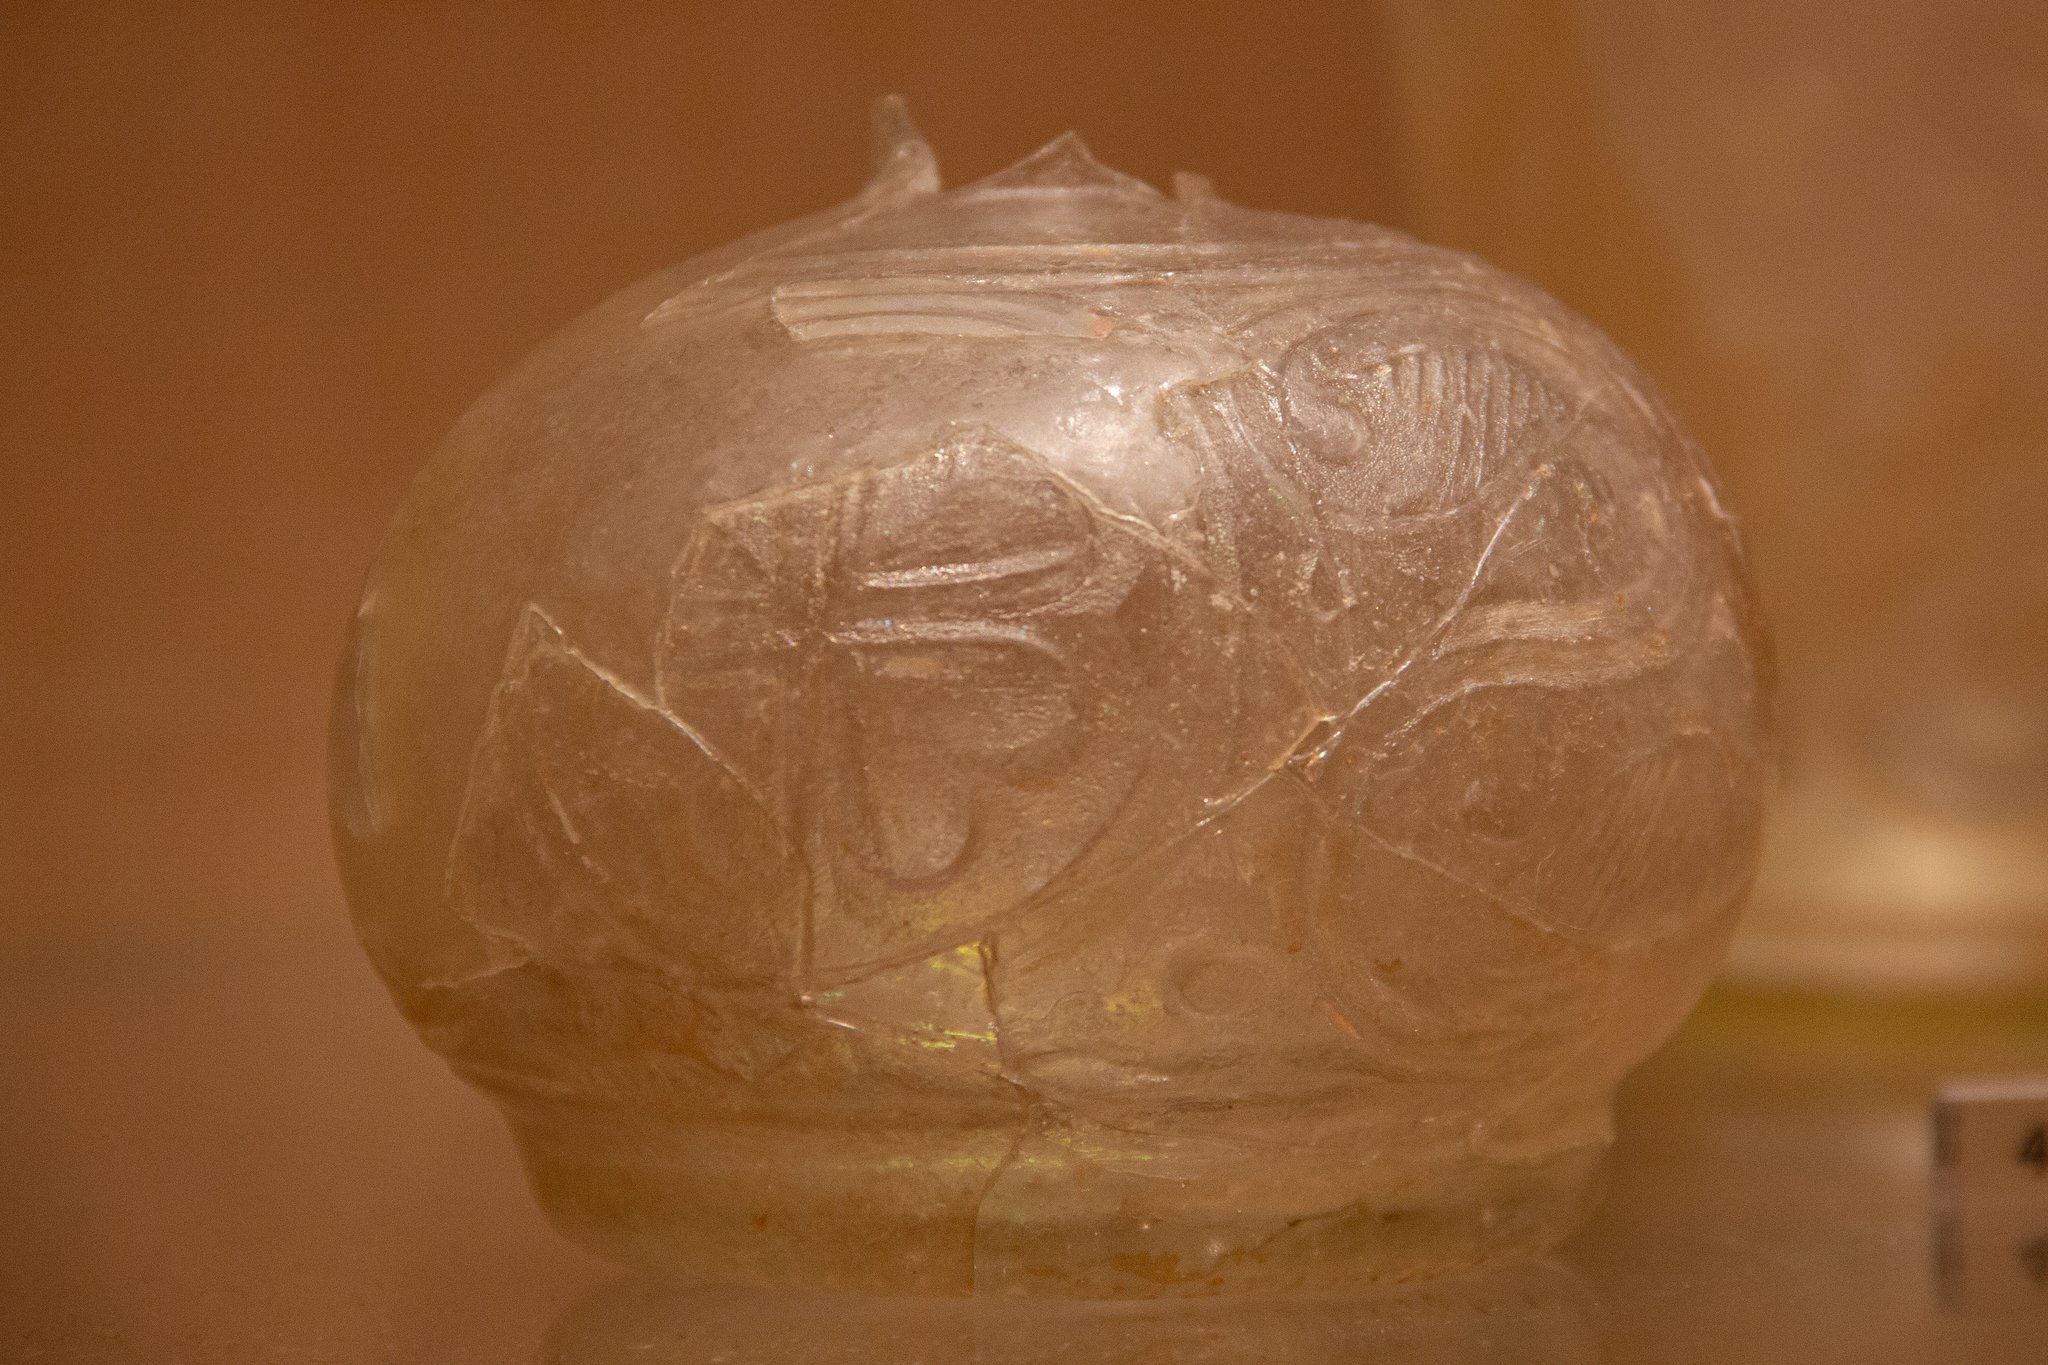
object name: bottle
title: Flask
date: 901-1000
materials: glass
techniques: glassblowing, cutting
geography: iran